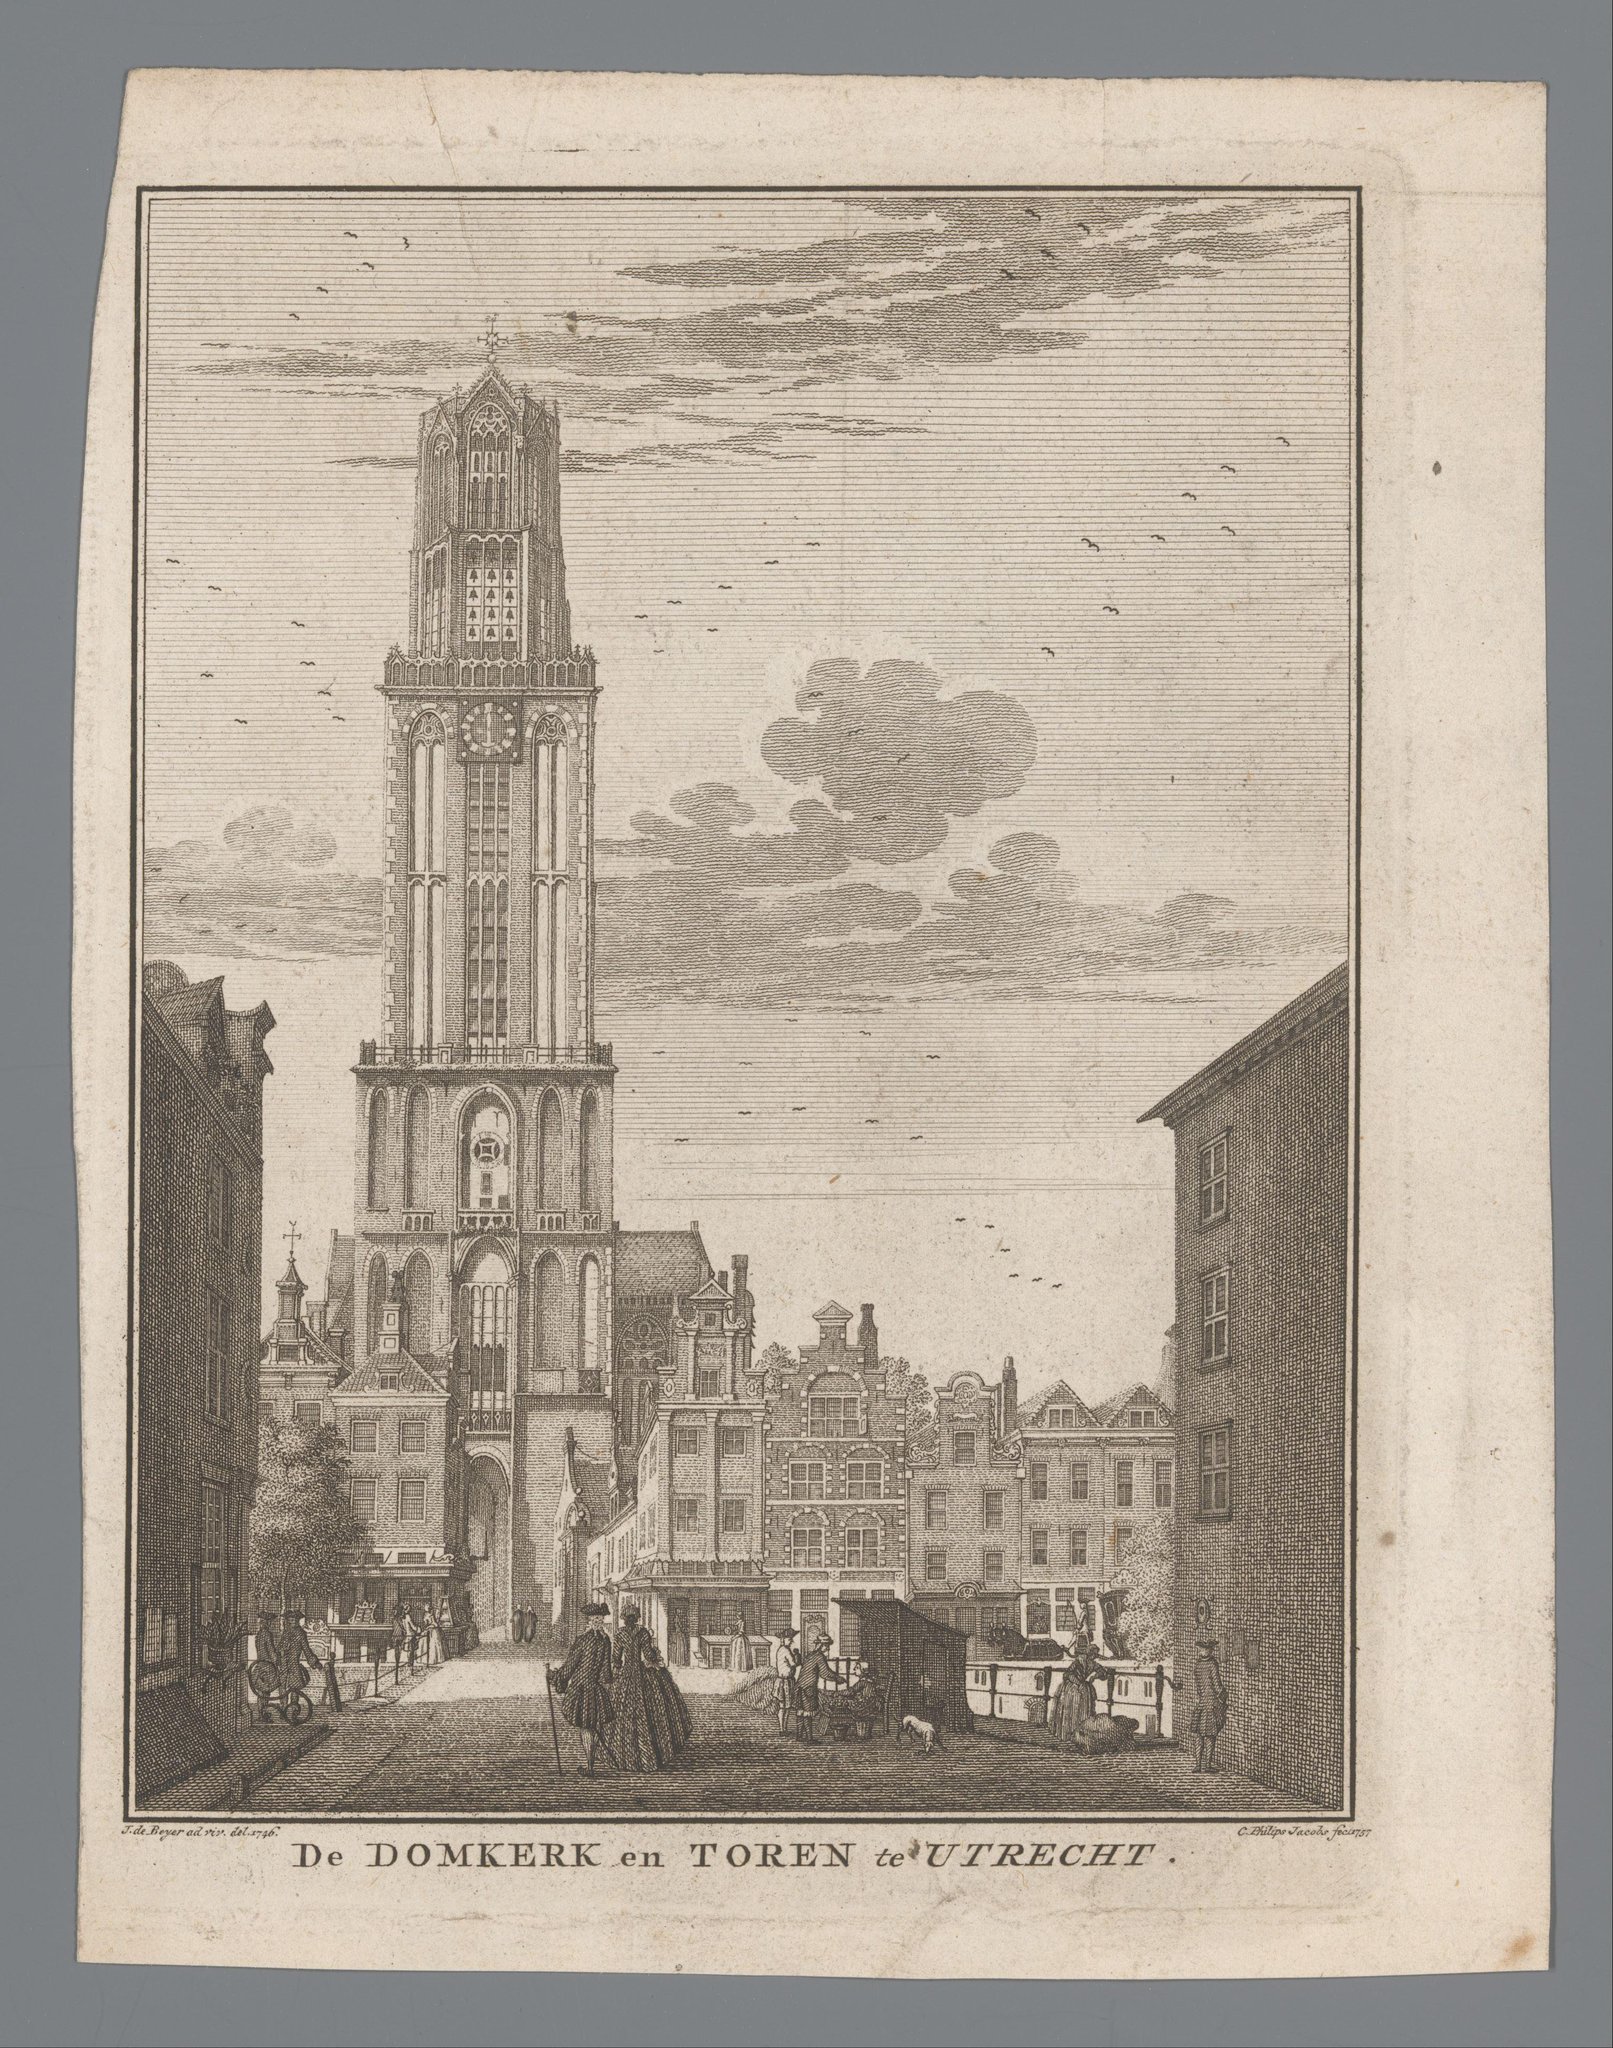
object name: print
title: De Domkerk en Toren te Utrecht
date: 1757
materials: paper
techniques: etching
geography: amsterdam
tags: city-view in general; 'veduta', church (exterior), utrecht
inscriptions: date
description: Gezicht op de Domtoren te Utrecht, gezien vanaf de brug. Op de voorgrond een wandelend paar en een kraam. Rechts een man die tegen een muur aan plast.